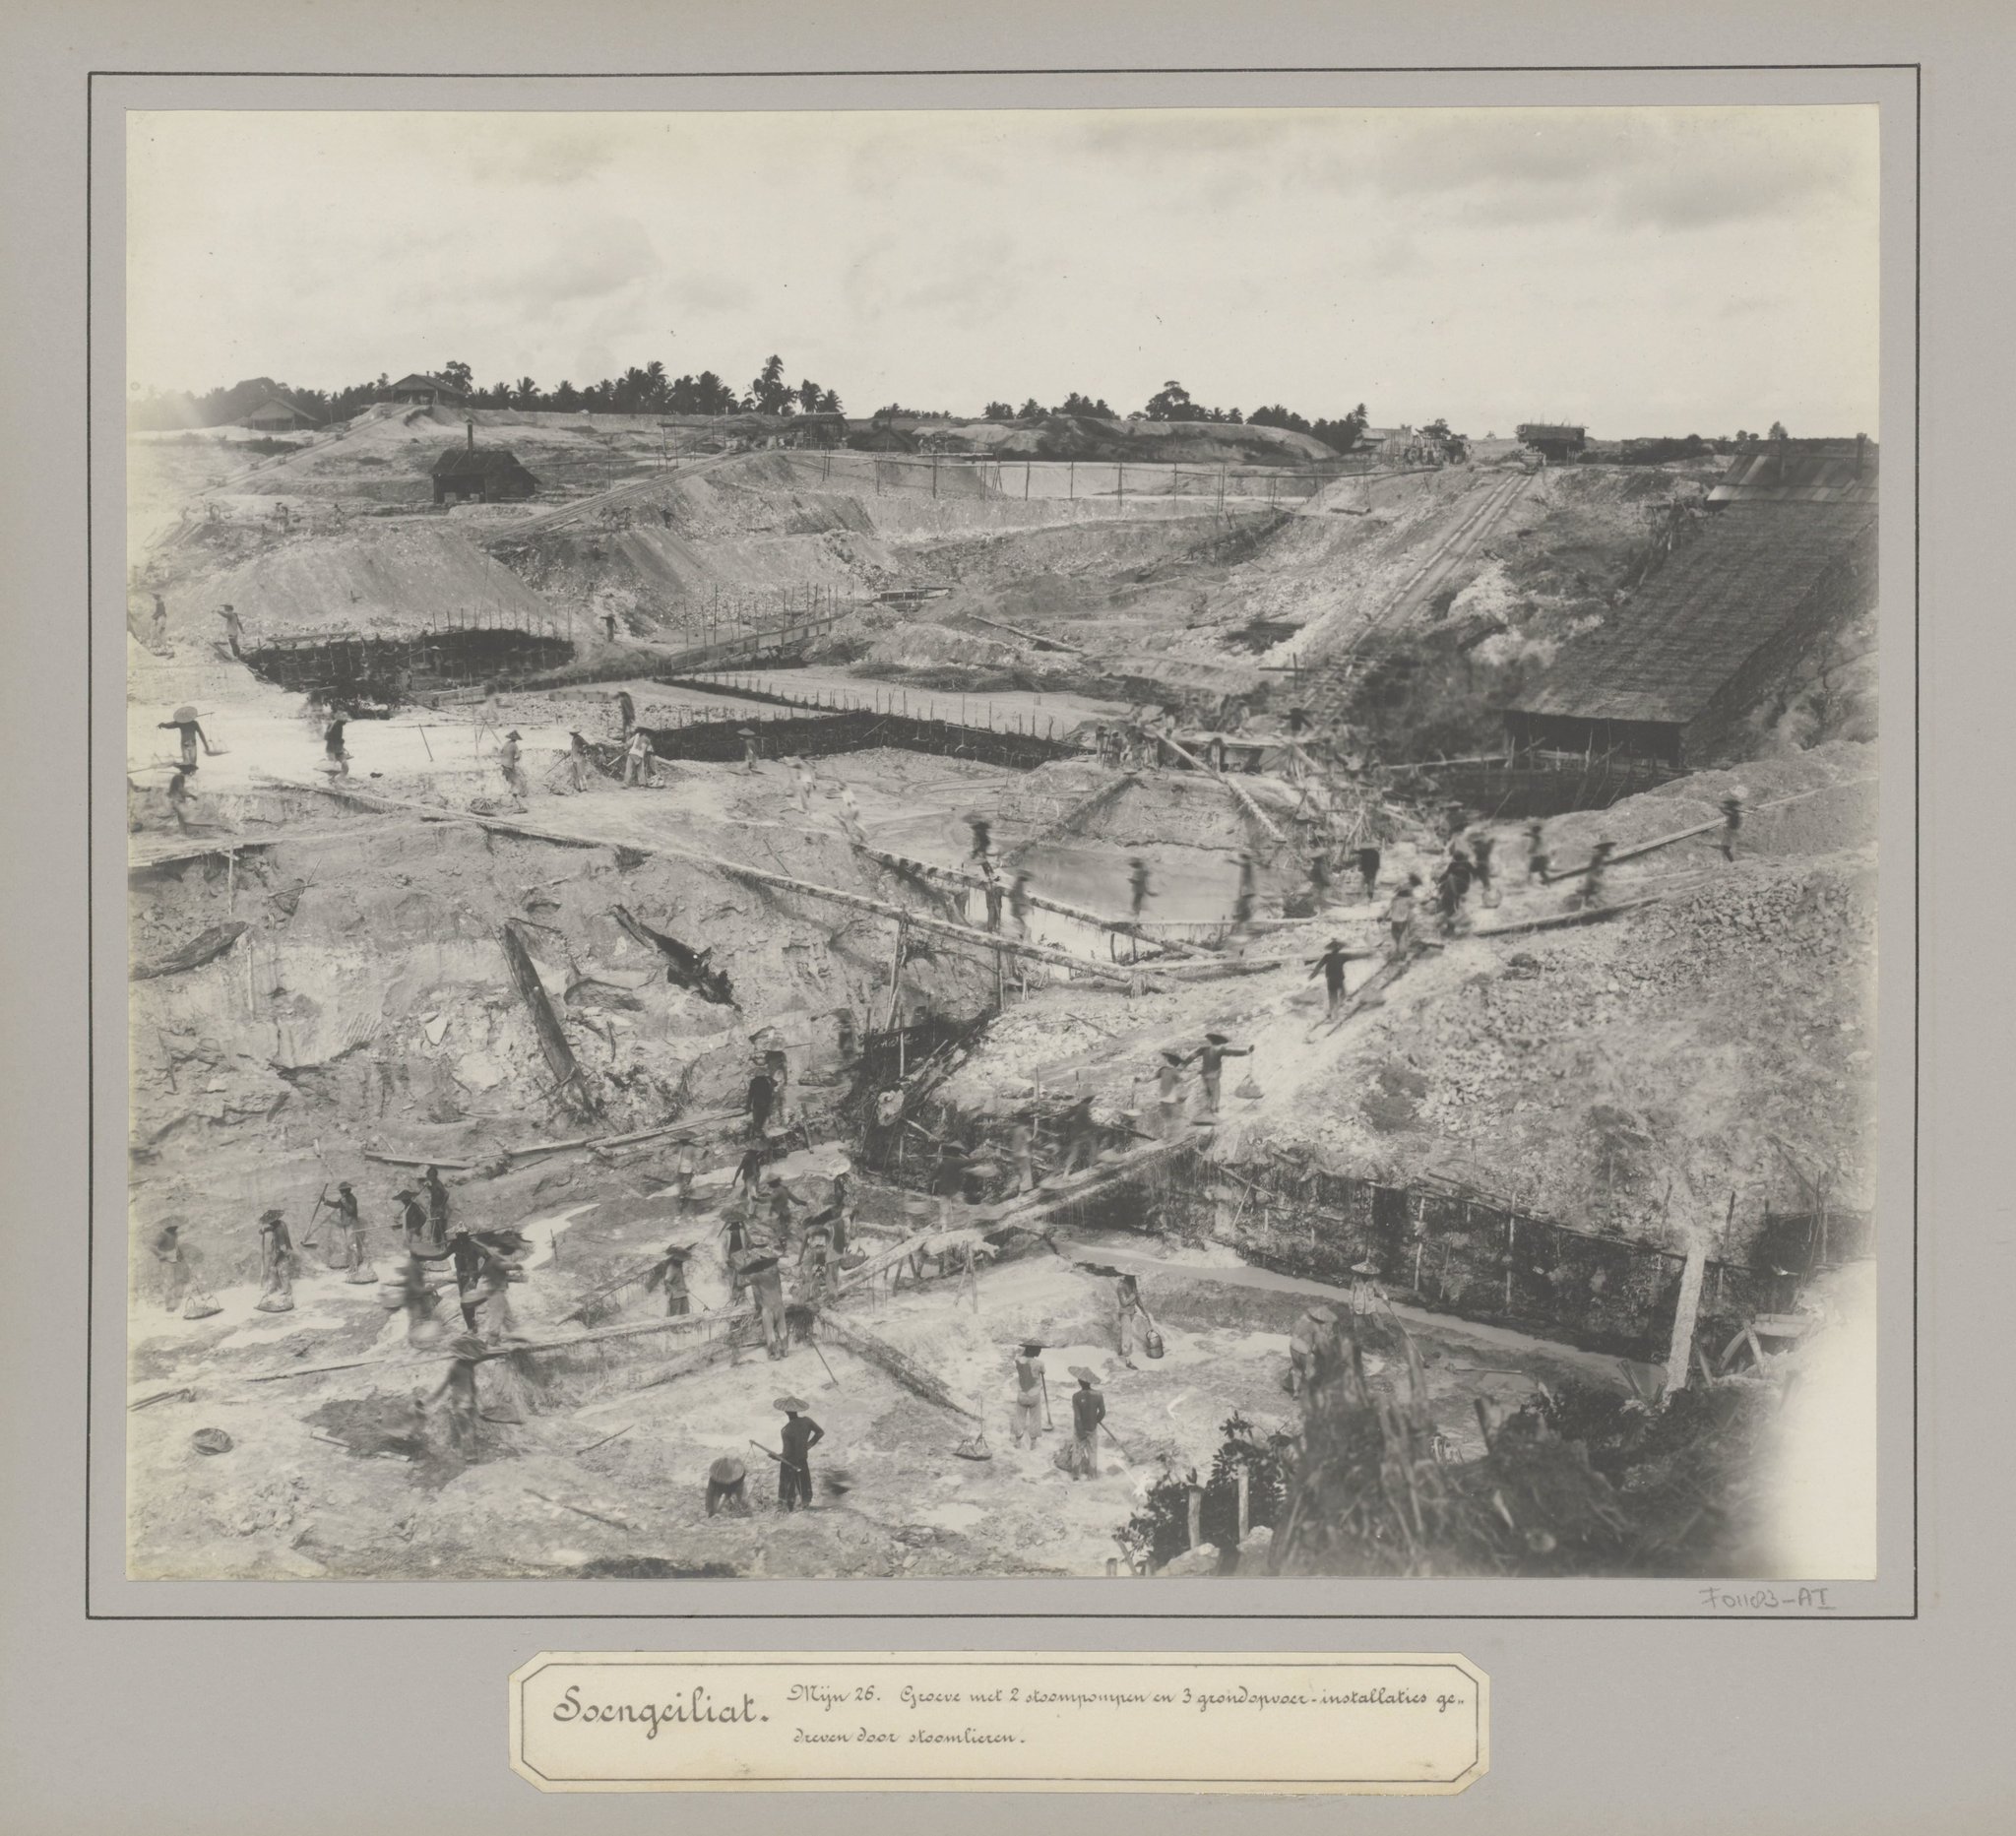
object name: photograph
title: Gezicht op een tingroeve te Soengeiliat met pompen, graafinstallaties en mijnwerkers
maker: Anonymous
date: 1900-1920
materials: photographic support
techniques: gelatin silver print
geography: soengeiliat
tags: mining, minerals and metals: tin, working class, labourers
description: Onderdeel van Fotoalbum over de tinwinning op Bangka.